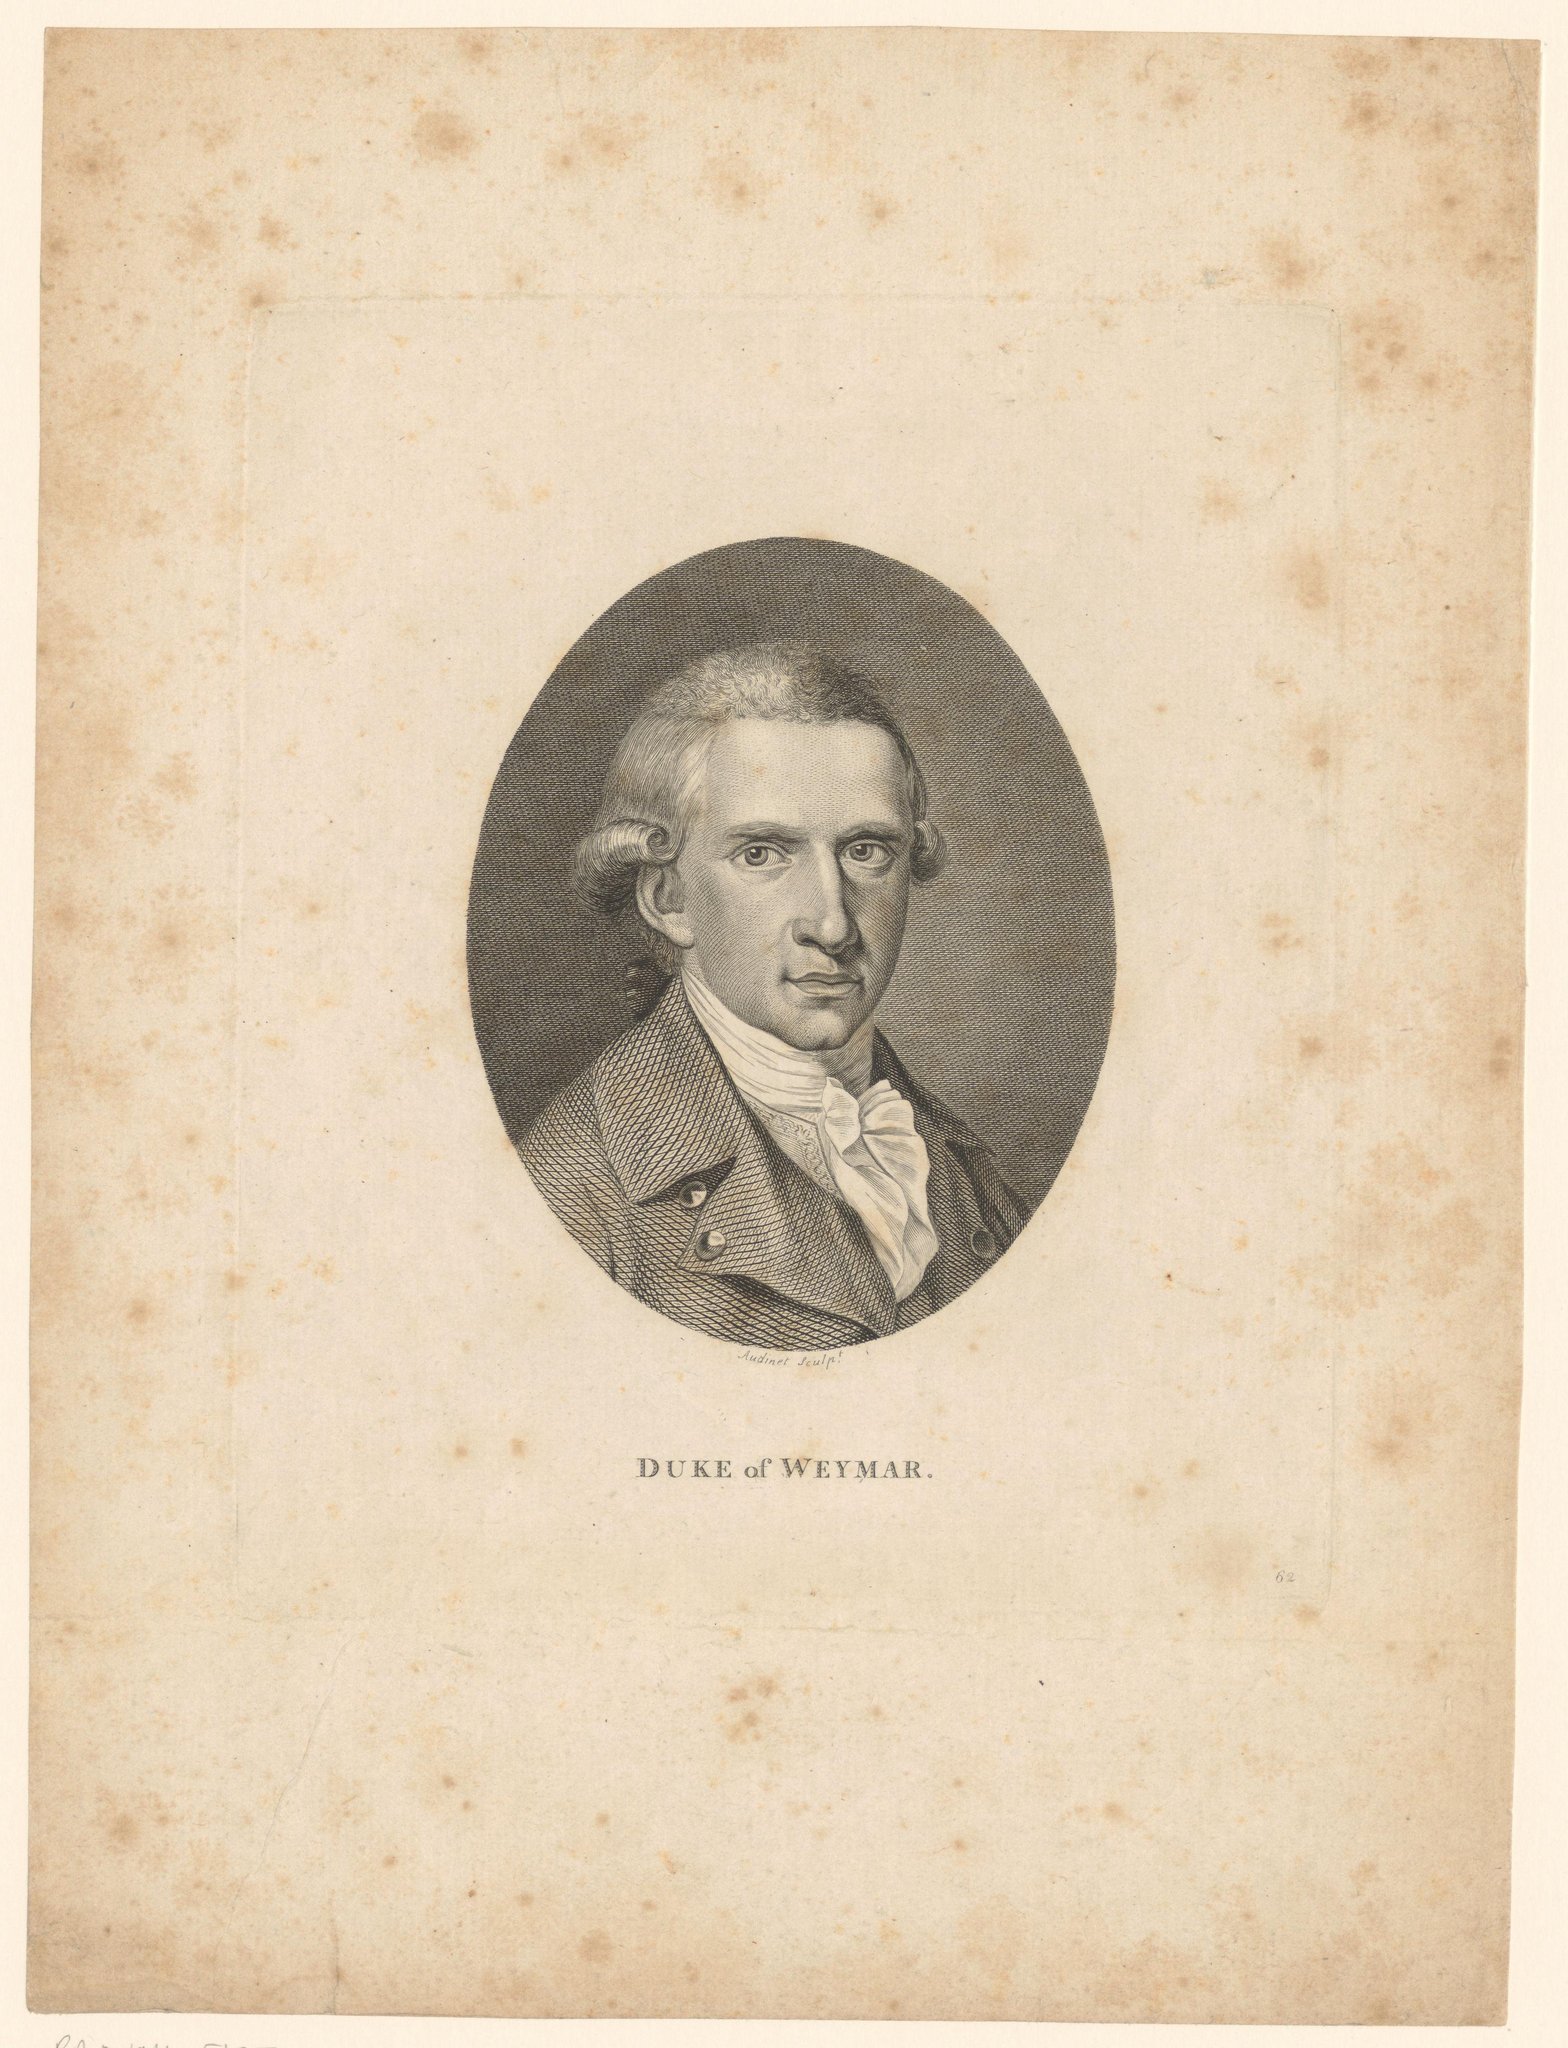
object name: print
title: Portret van Karel August Willem Nicolaas van Saksen-Weimar-Eisenach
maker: philip audinet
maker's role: print maker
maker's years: 1766-1837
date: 1815-1820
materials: paper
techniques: engraving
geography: london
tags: historical persons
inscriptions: collector's mark: Lugt 2228